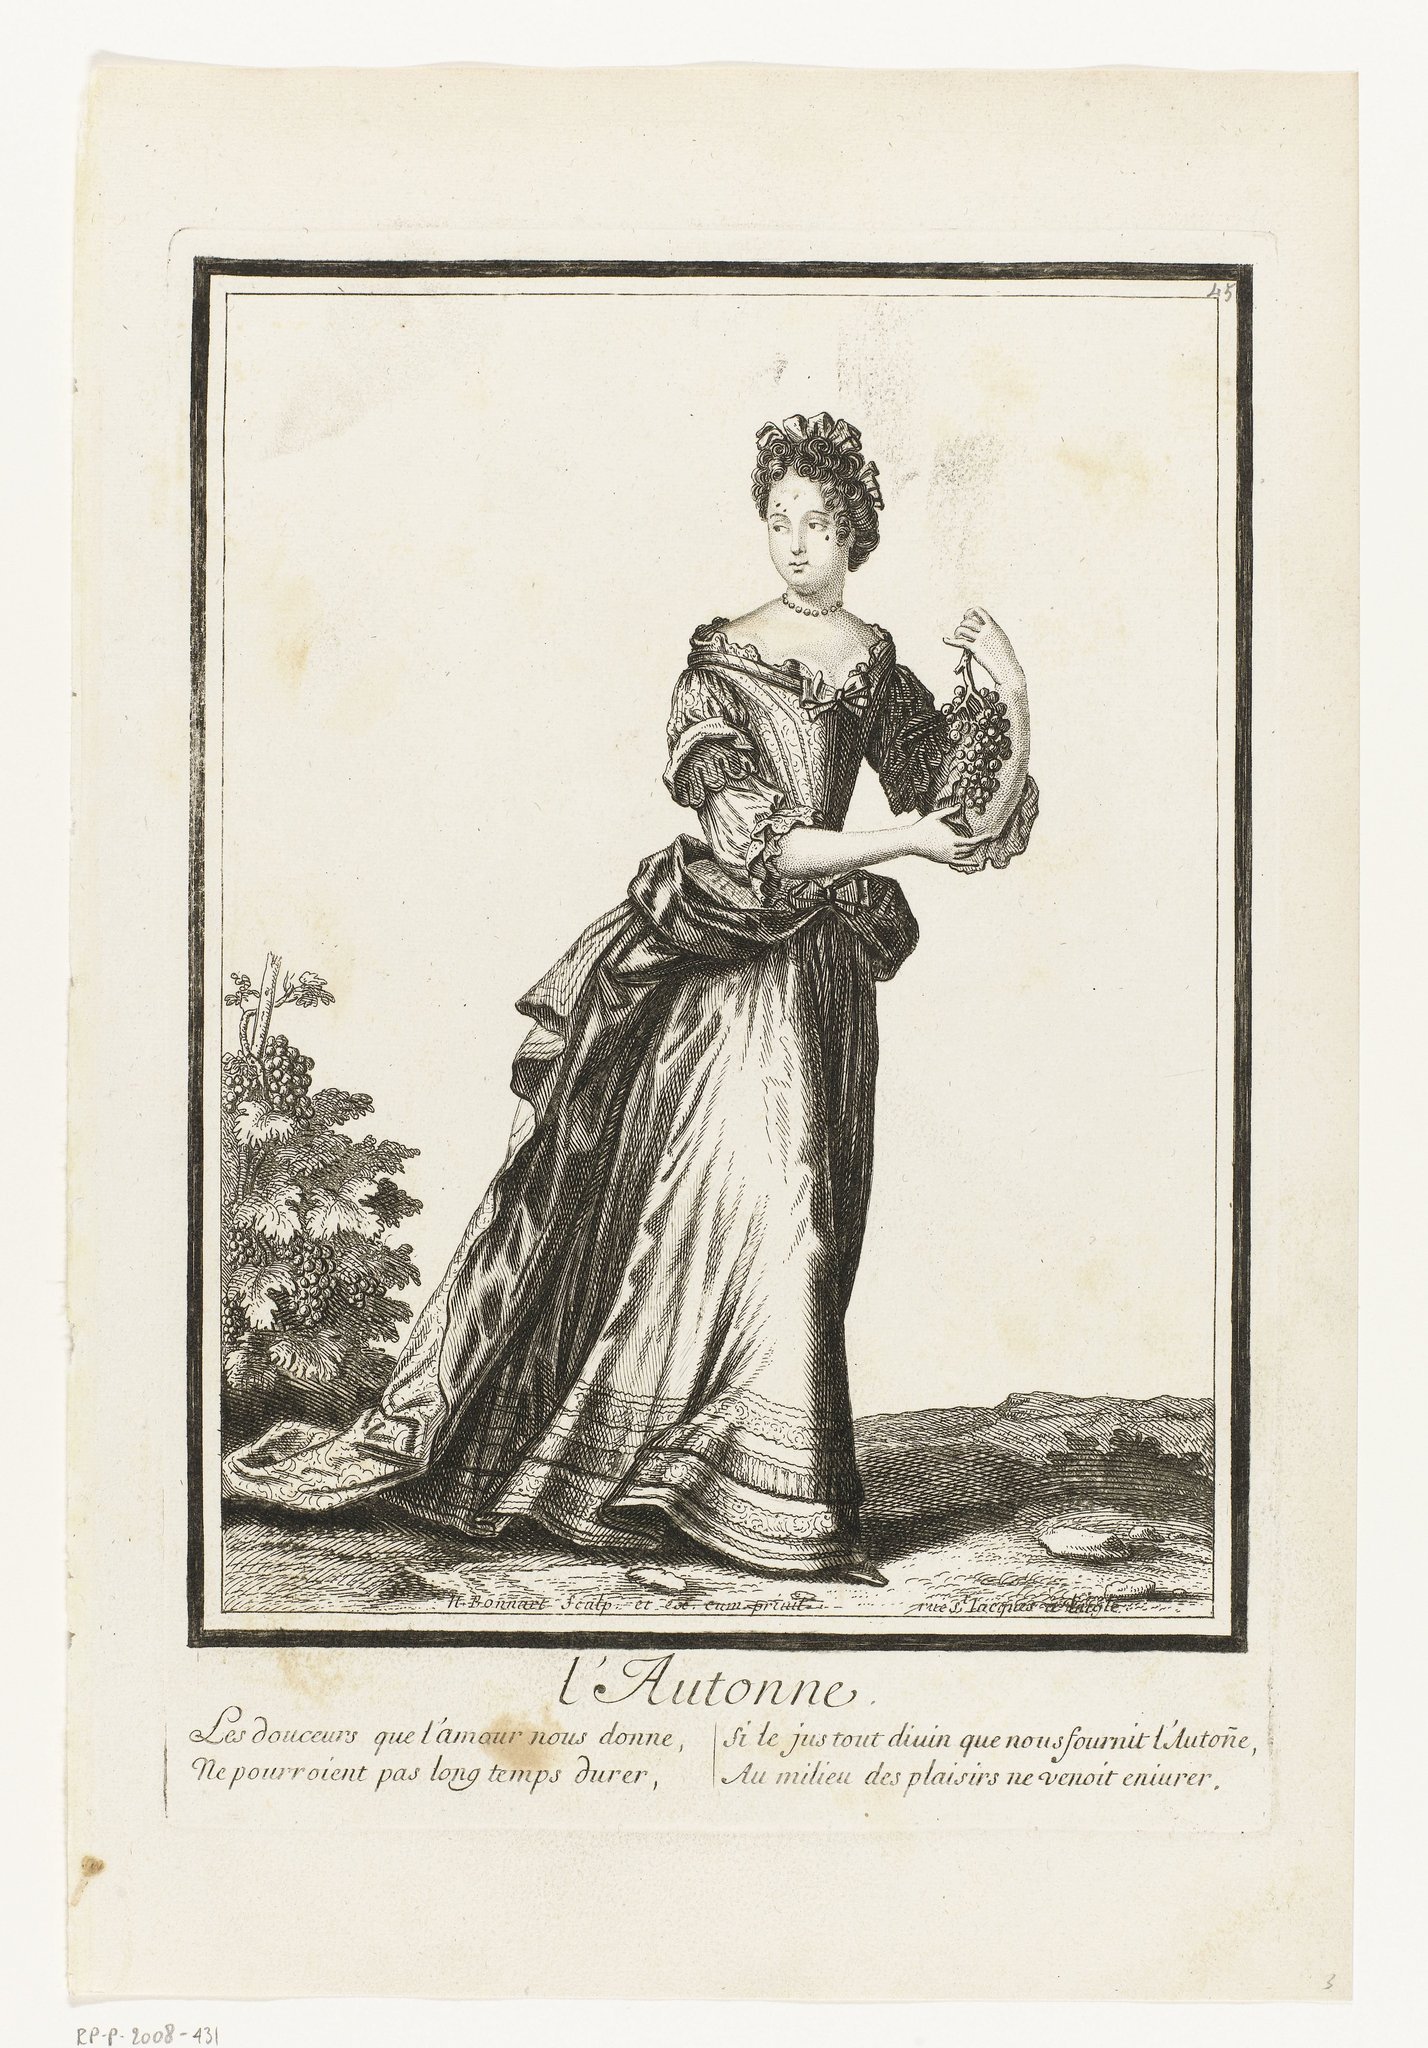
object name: print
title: Personificaties van de vier seizoenen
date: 1647-1718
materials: paper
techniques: engraving, etching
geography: france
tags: year divided into four seasons, vintage, grape harvest, autumn, fall, 'autumnus'; 'autunno' (ripa), bunch of grapes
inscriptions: collector's mark: Lugt 2228, collector's mark: Lugt 2228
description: Maakt deel uit van een vierdelige serie met personificaties van de vier seizoenen.